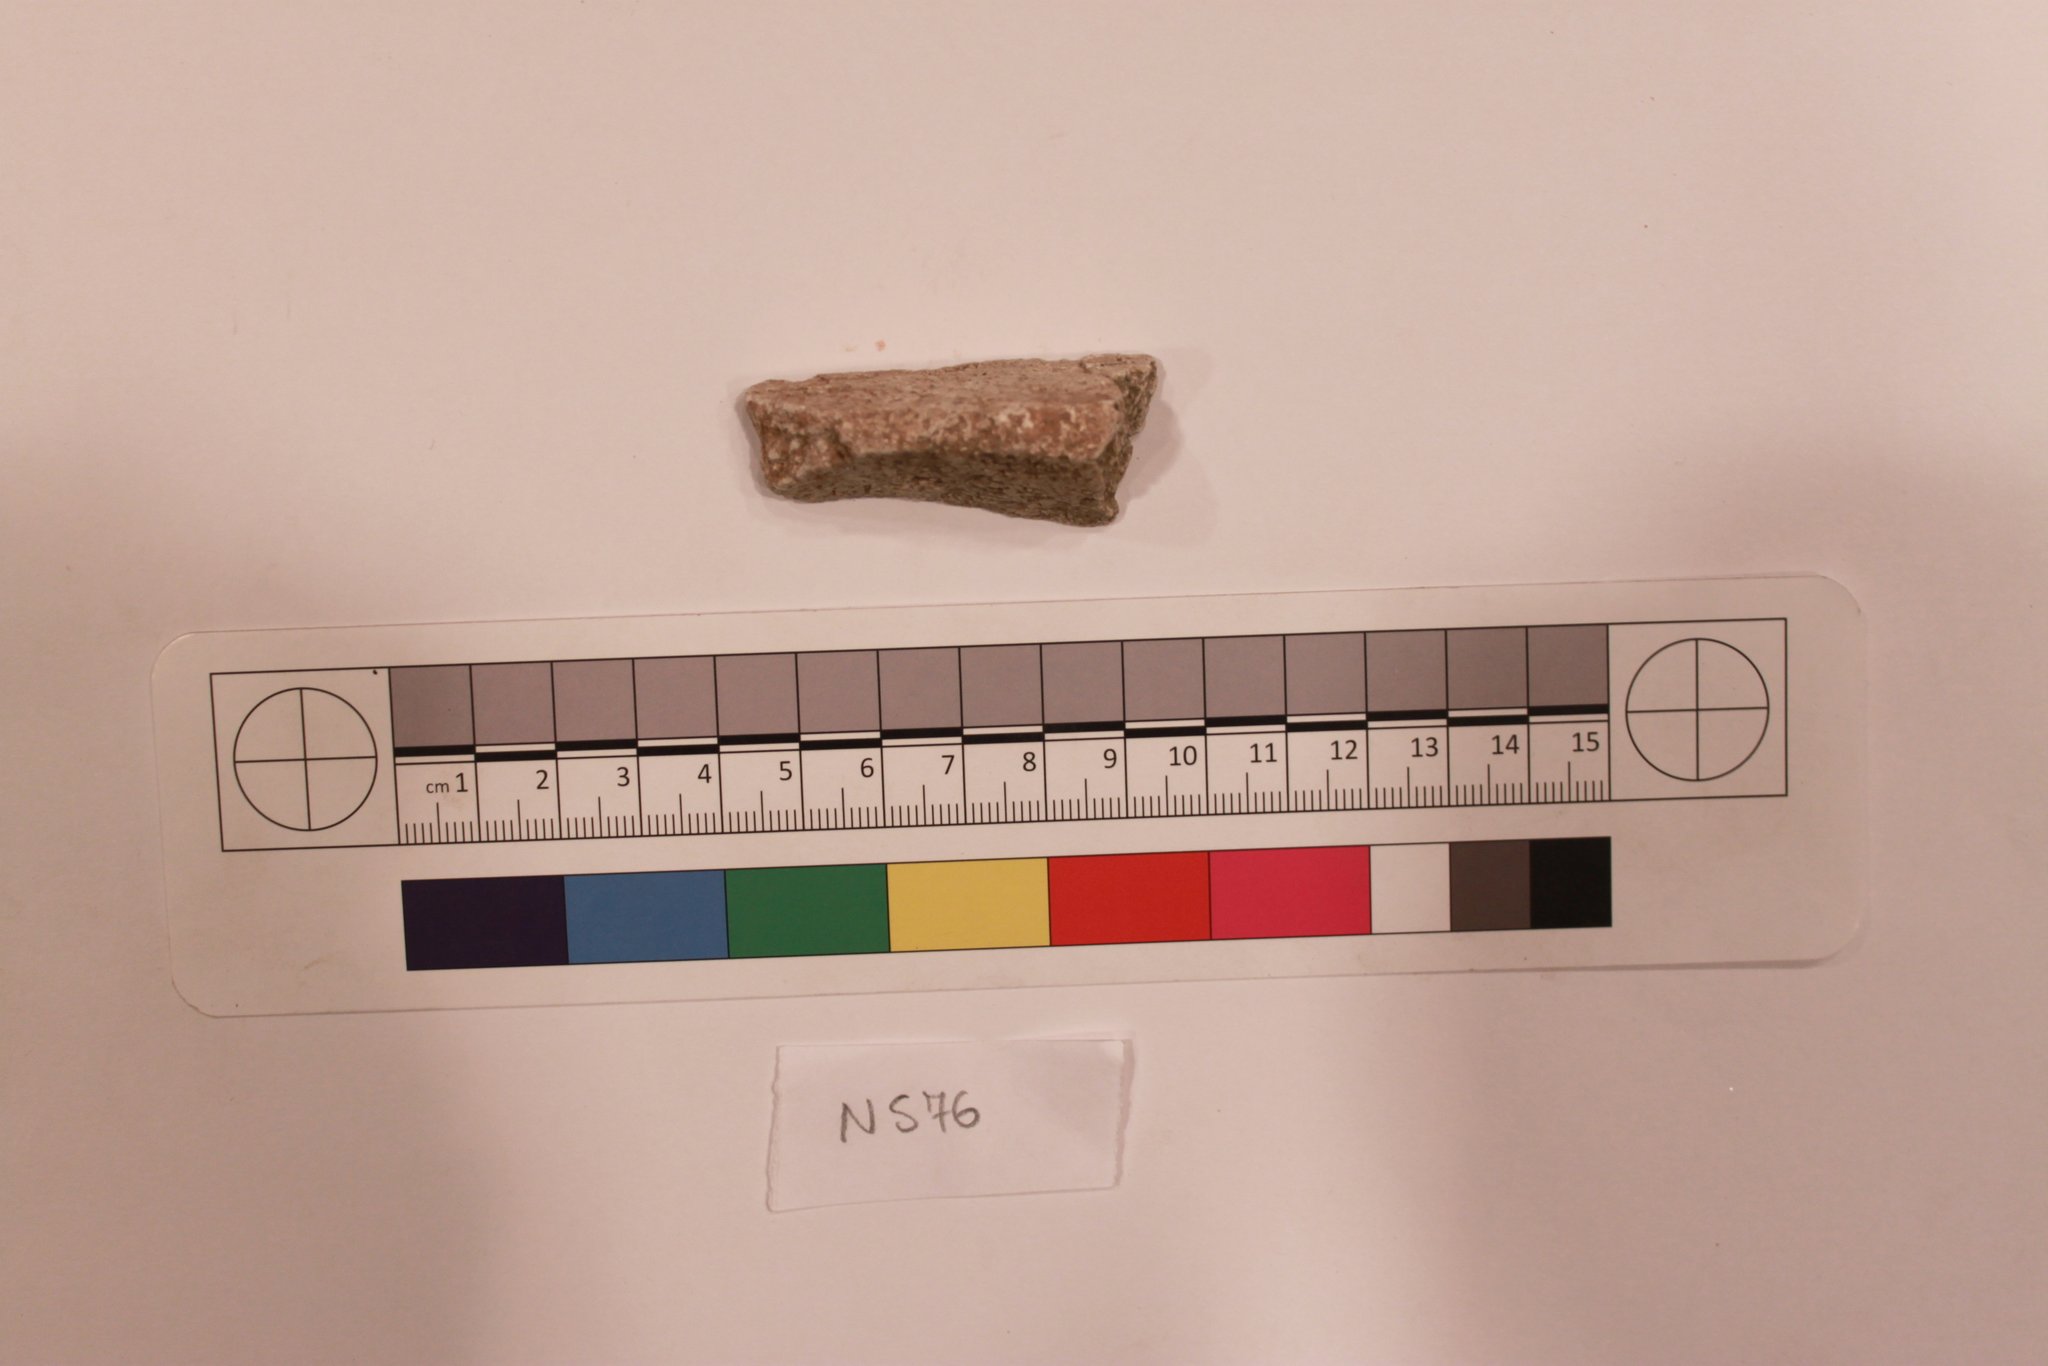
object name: fragment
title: Stucco Fragment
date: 701-1200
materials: plaster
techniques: carving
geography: iran